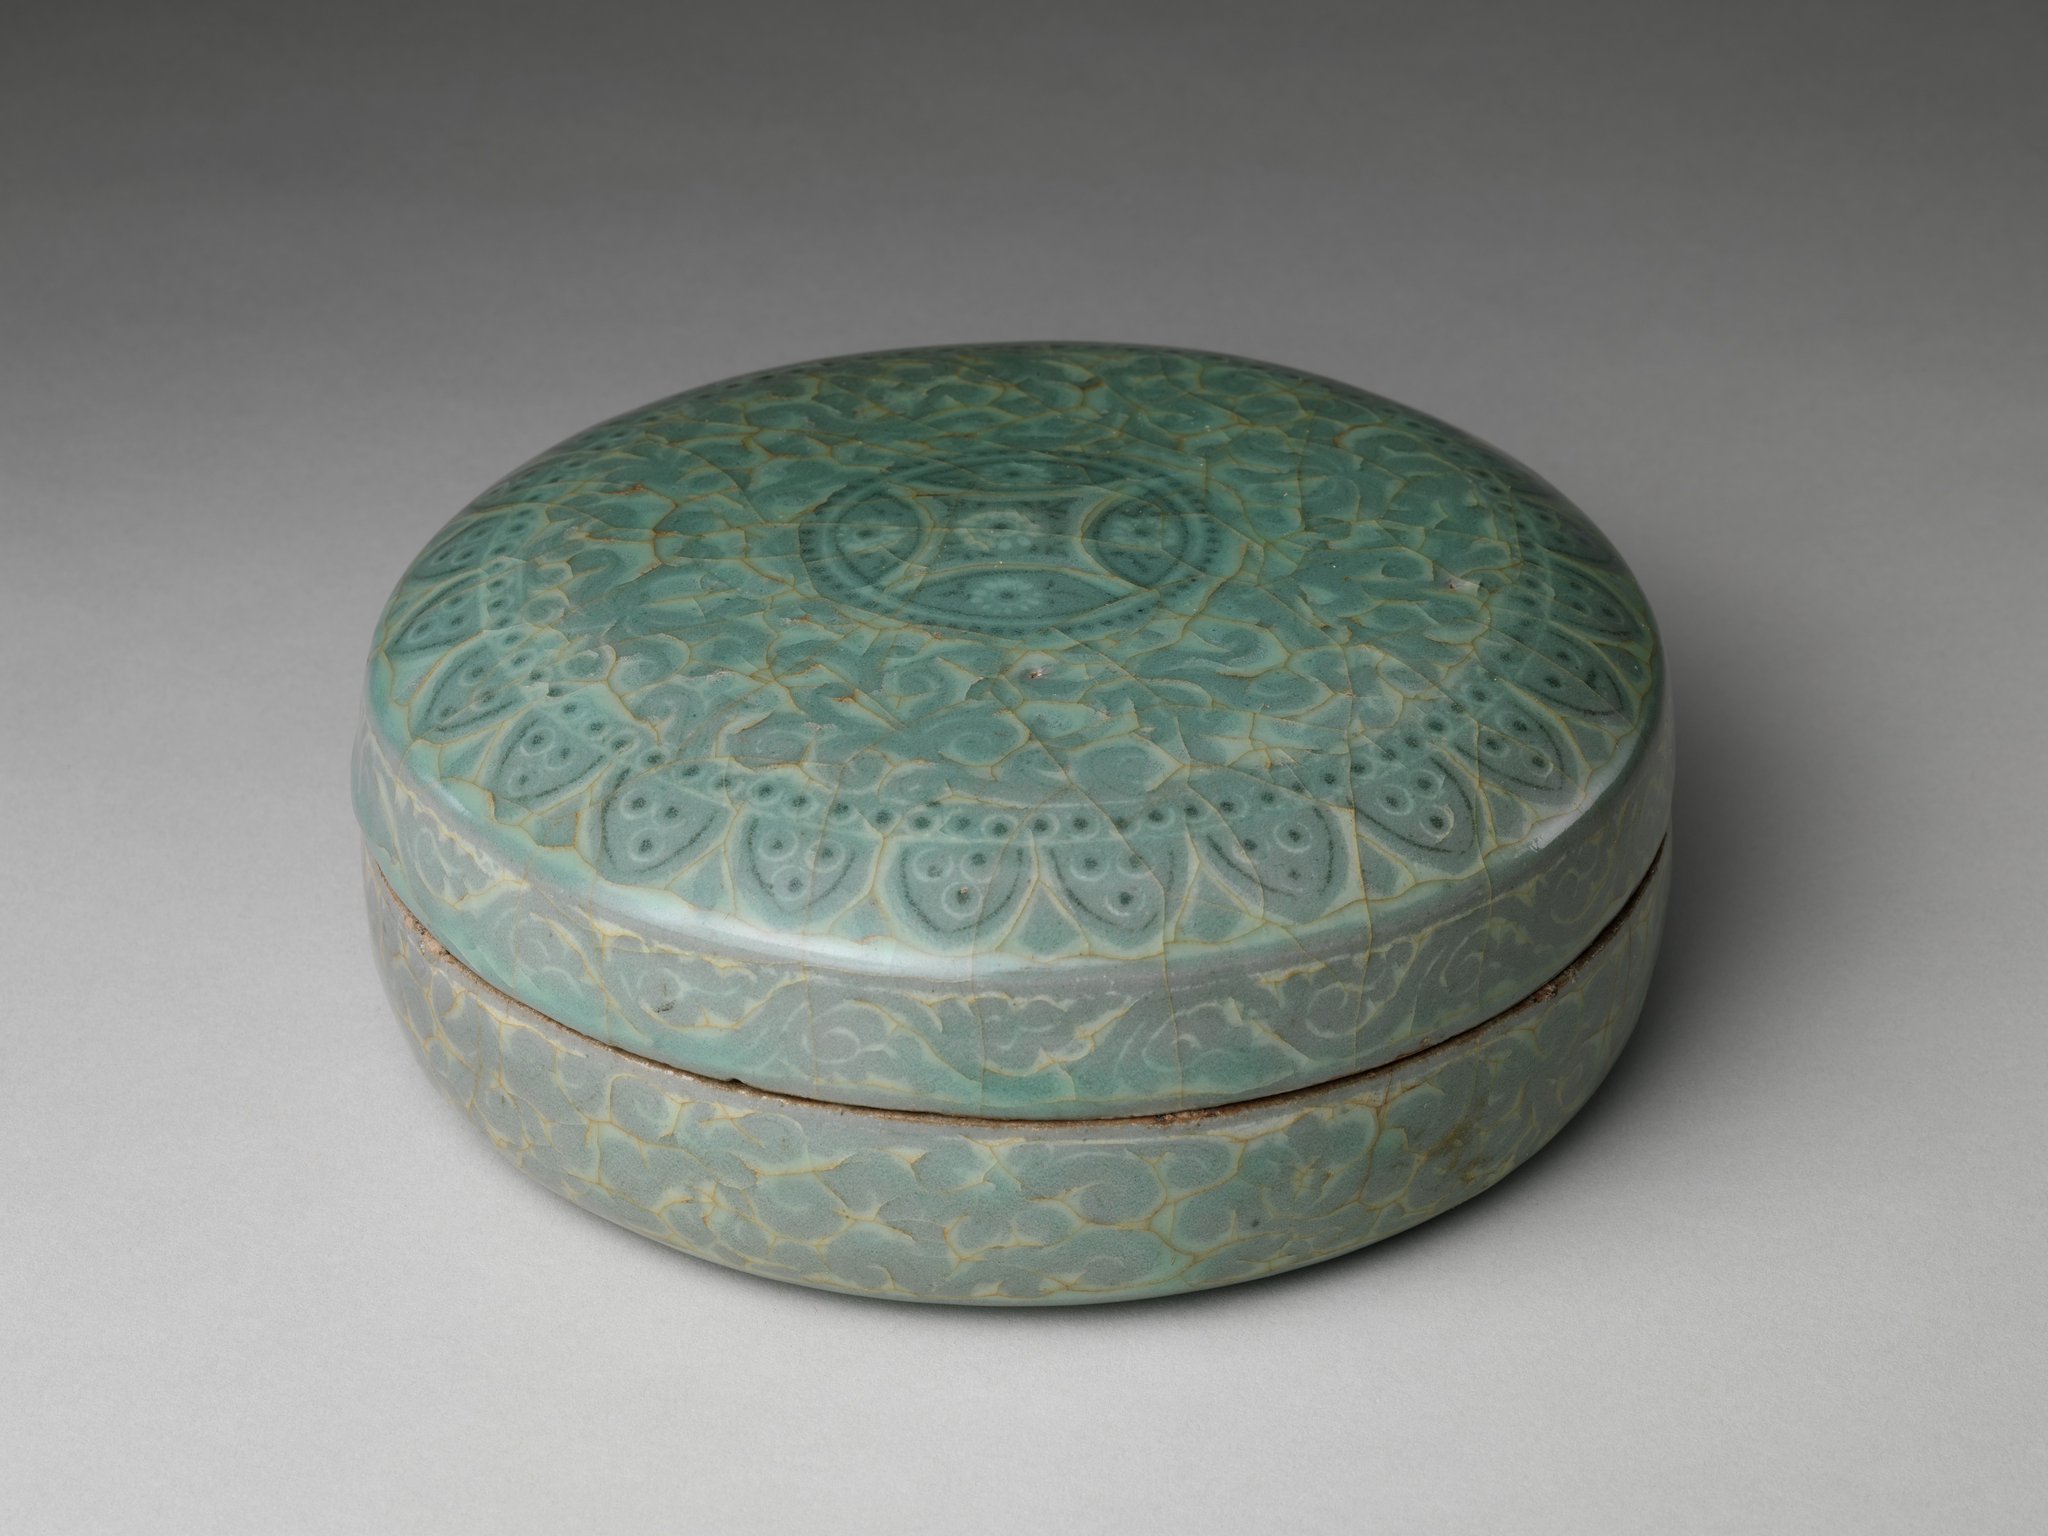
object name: covered box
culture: korean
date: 1201-1300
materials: ceramic glaze, glaze, stoneware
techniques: inlay